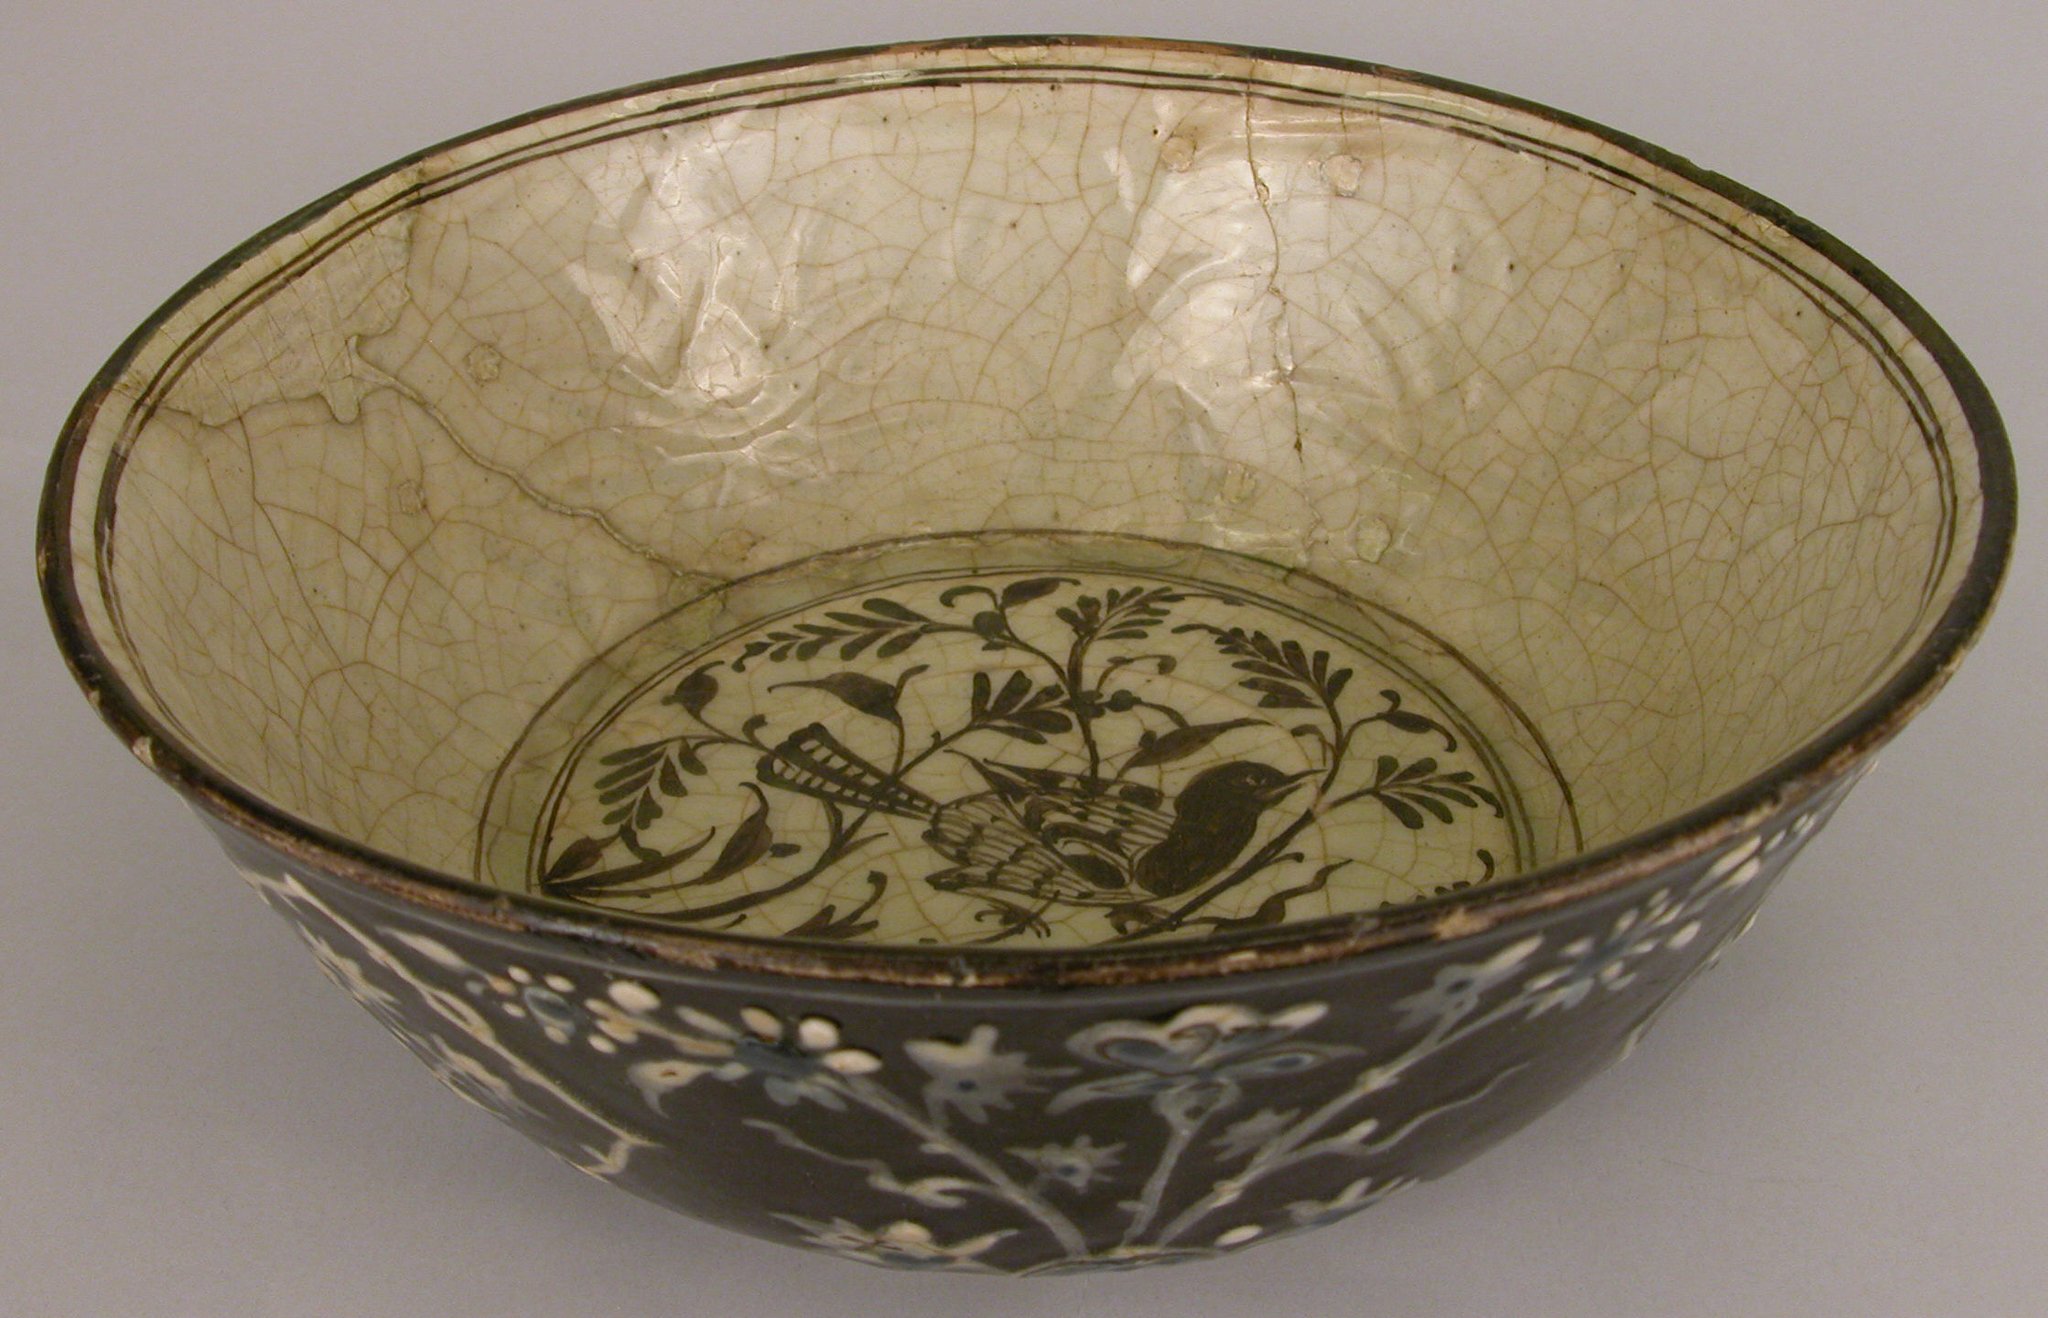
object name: bowl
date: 1701-1800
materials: stonepaste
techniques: glazing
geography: iran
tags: birds